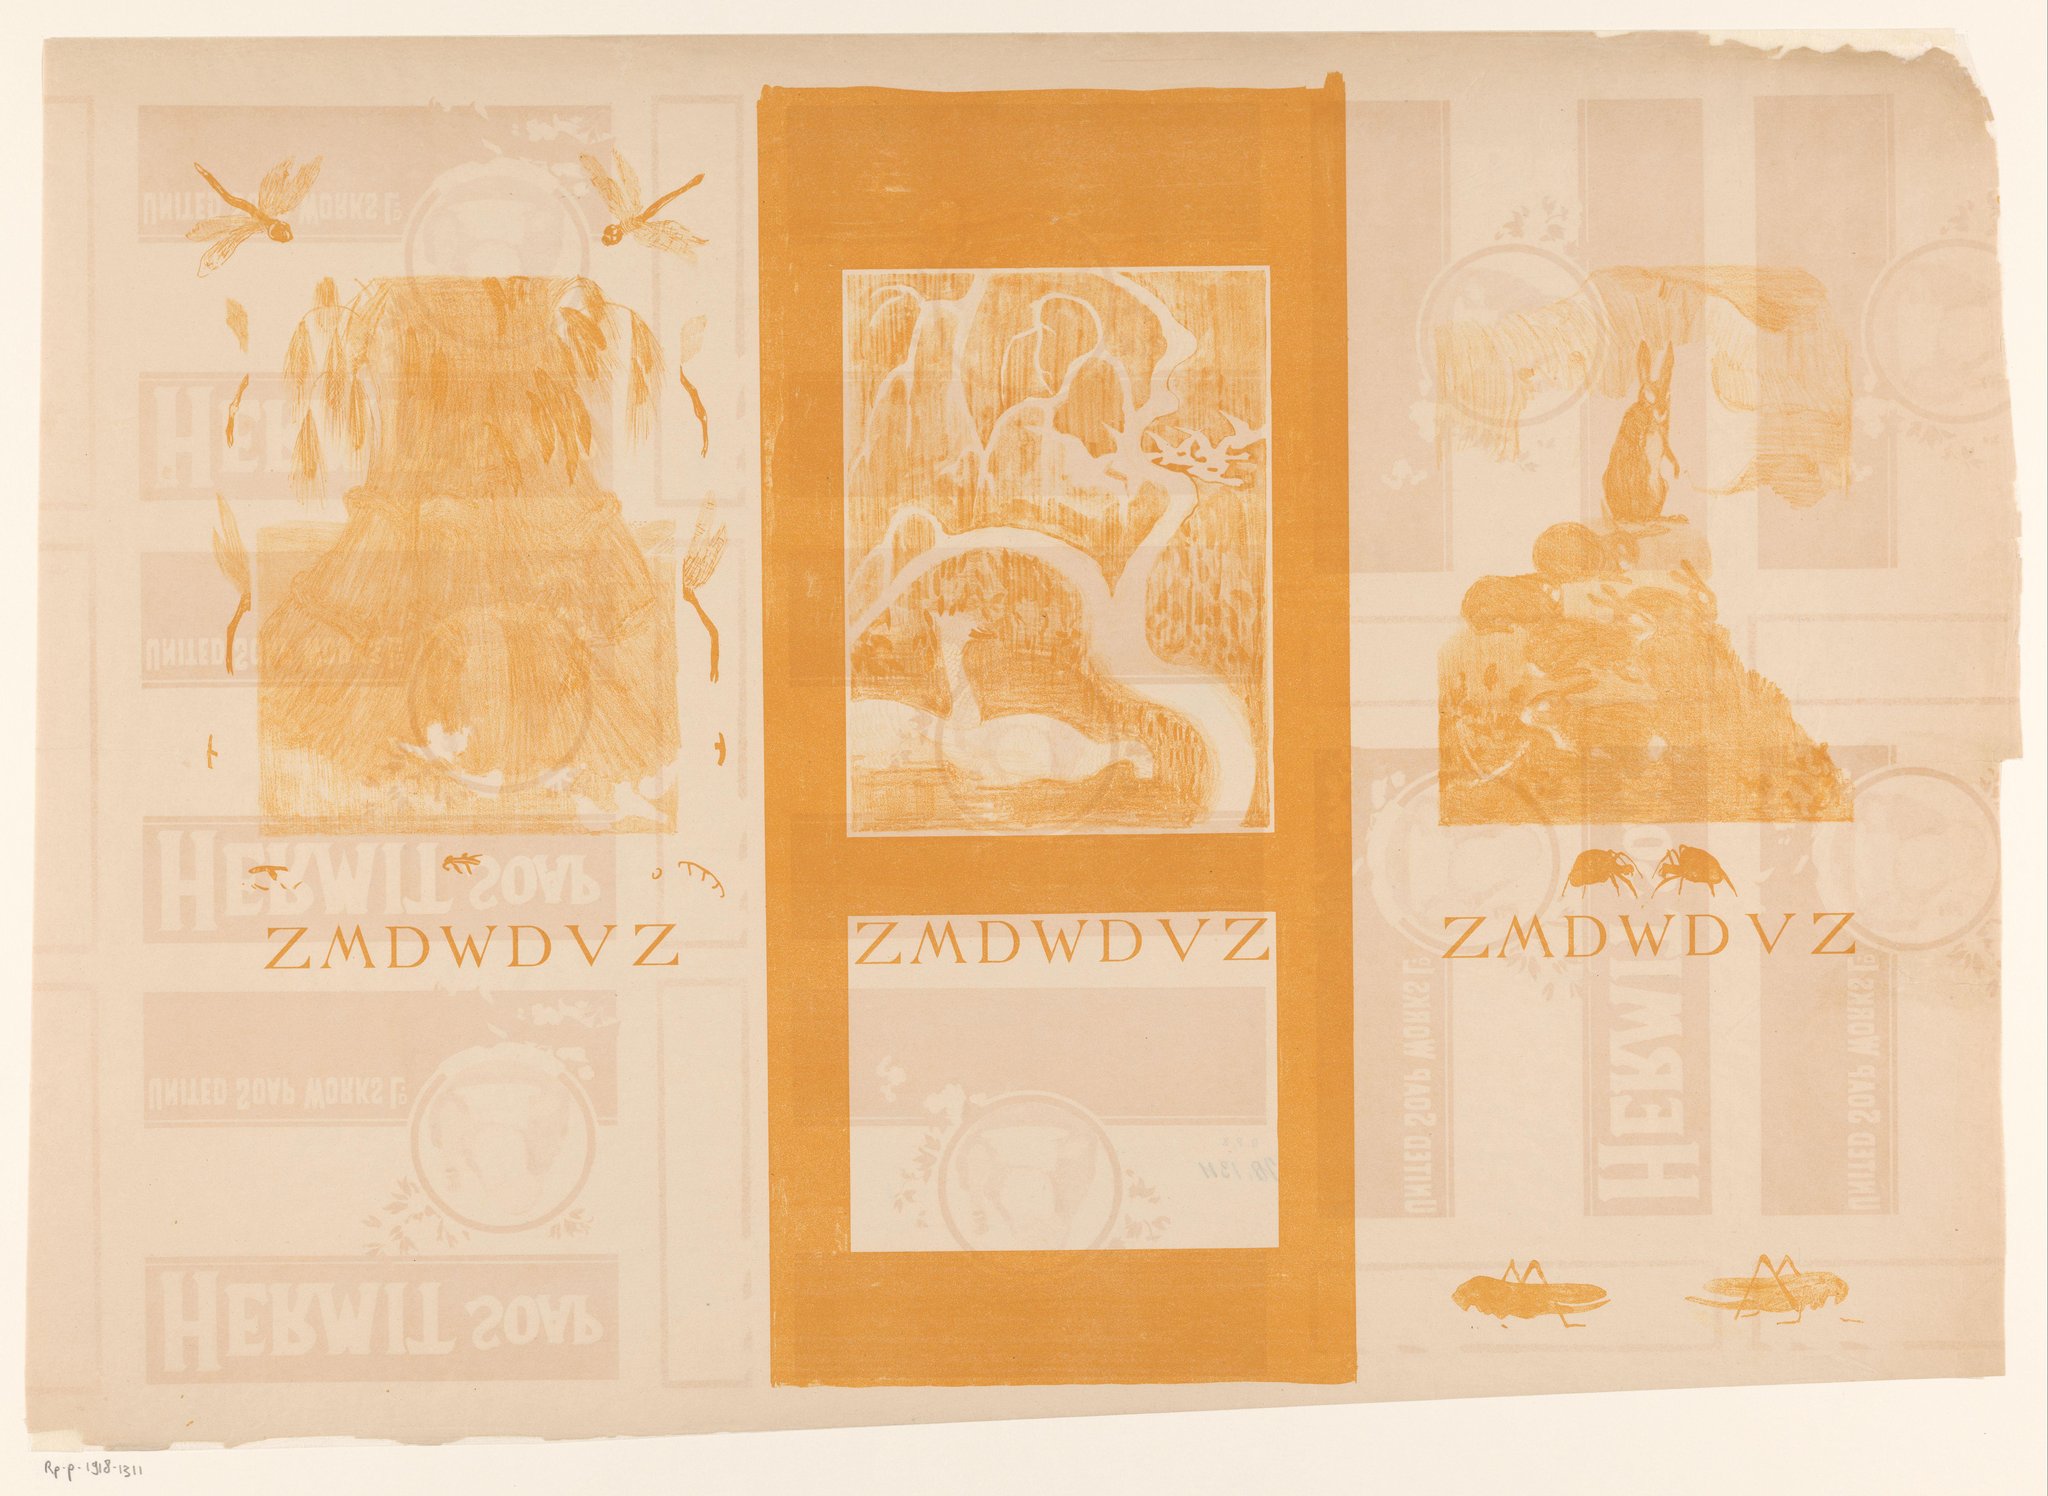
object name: calendar leaf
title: Kalenderbladen van juli, oktober en september, met korenschoven, zwanen en konijnen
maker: theo van hoytema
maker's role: draughtsman, painter, print maker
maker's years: 1863-1917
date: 1901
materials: paper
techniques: lithograph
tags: plants and herbs: wheat, calendar, almanac, water-birds: swan, rodents: rabbit